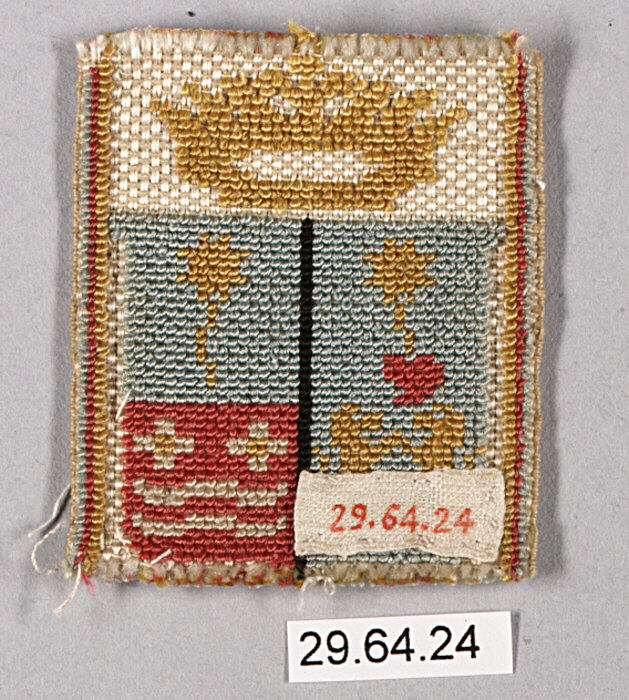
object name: galloon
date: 1701-1900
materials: silk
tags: flowers